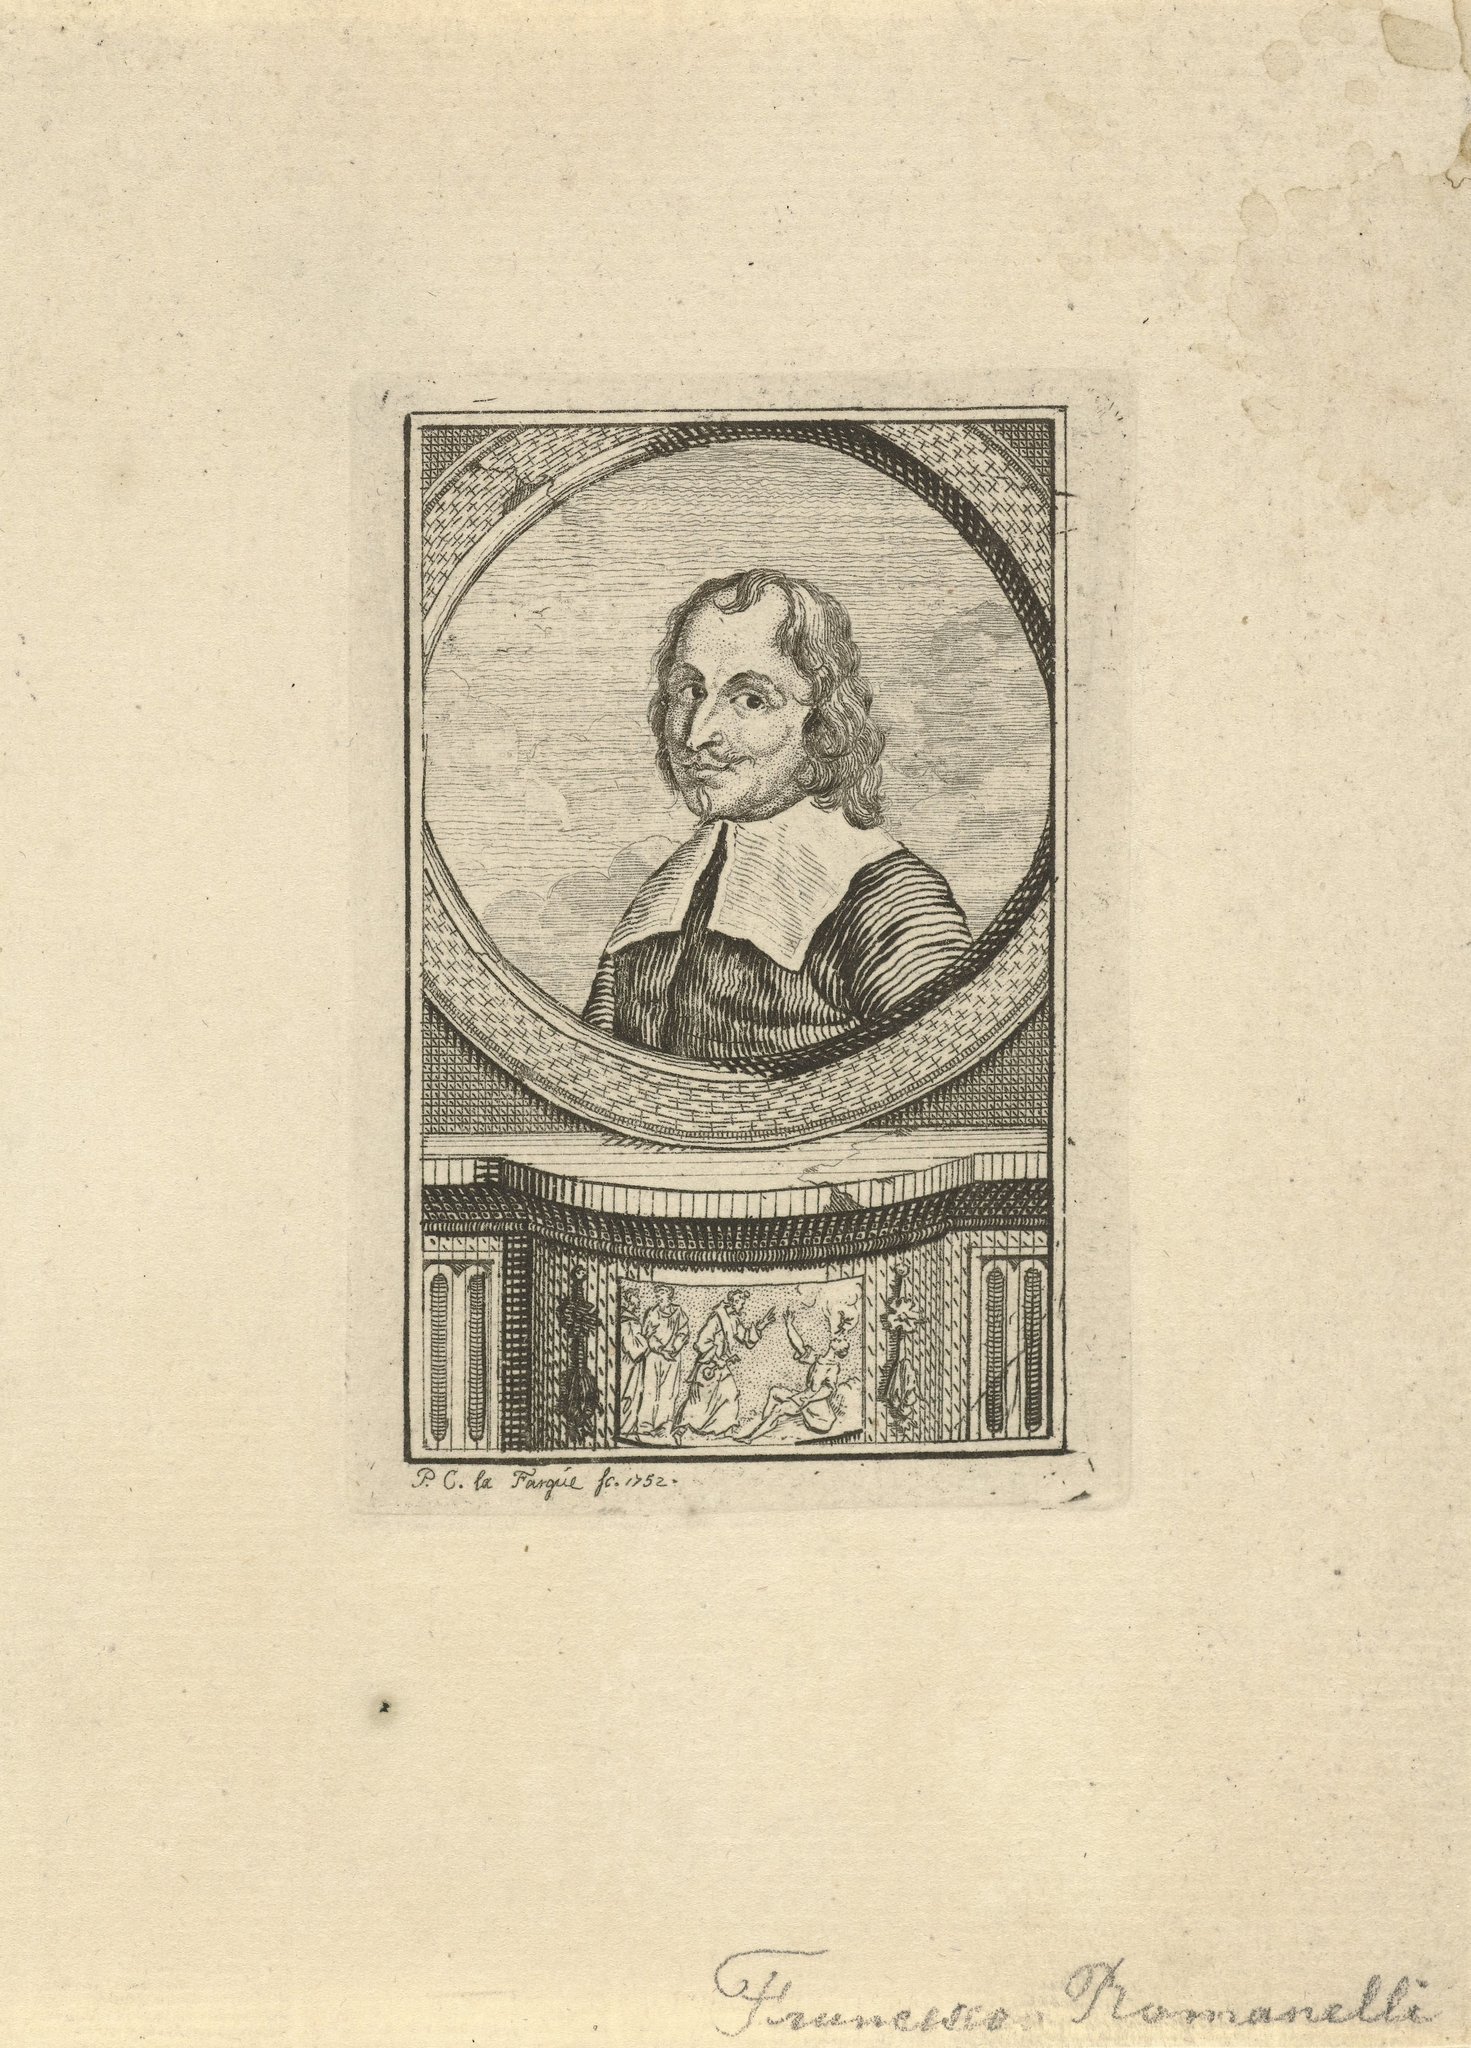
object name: print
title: Portretten van Italiaanse kunstenaars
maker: isaac lodewijk la fargue van nieuwland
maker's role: draughtsman, painter, print maker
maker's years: 1726-1805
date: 1752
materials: paper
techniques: etching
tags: draughtsman, giovanni francesco romanelli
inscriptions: collector's mark: Lugt 2228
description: Prent opgenomen in: Dézallier d'Argenville, Antoine Joseph. Tooneel der uitmuntende schilders van Europa, en byzonderlyk van Nederland. Den Haag: Mattheus Gaillard, 1752.